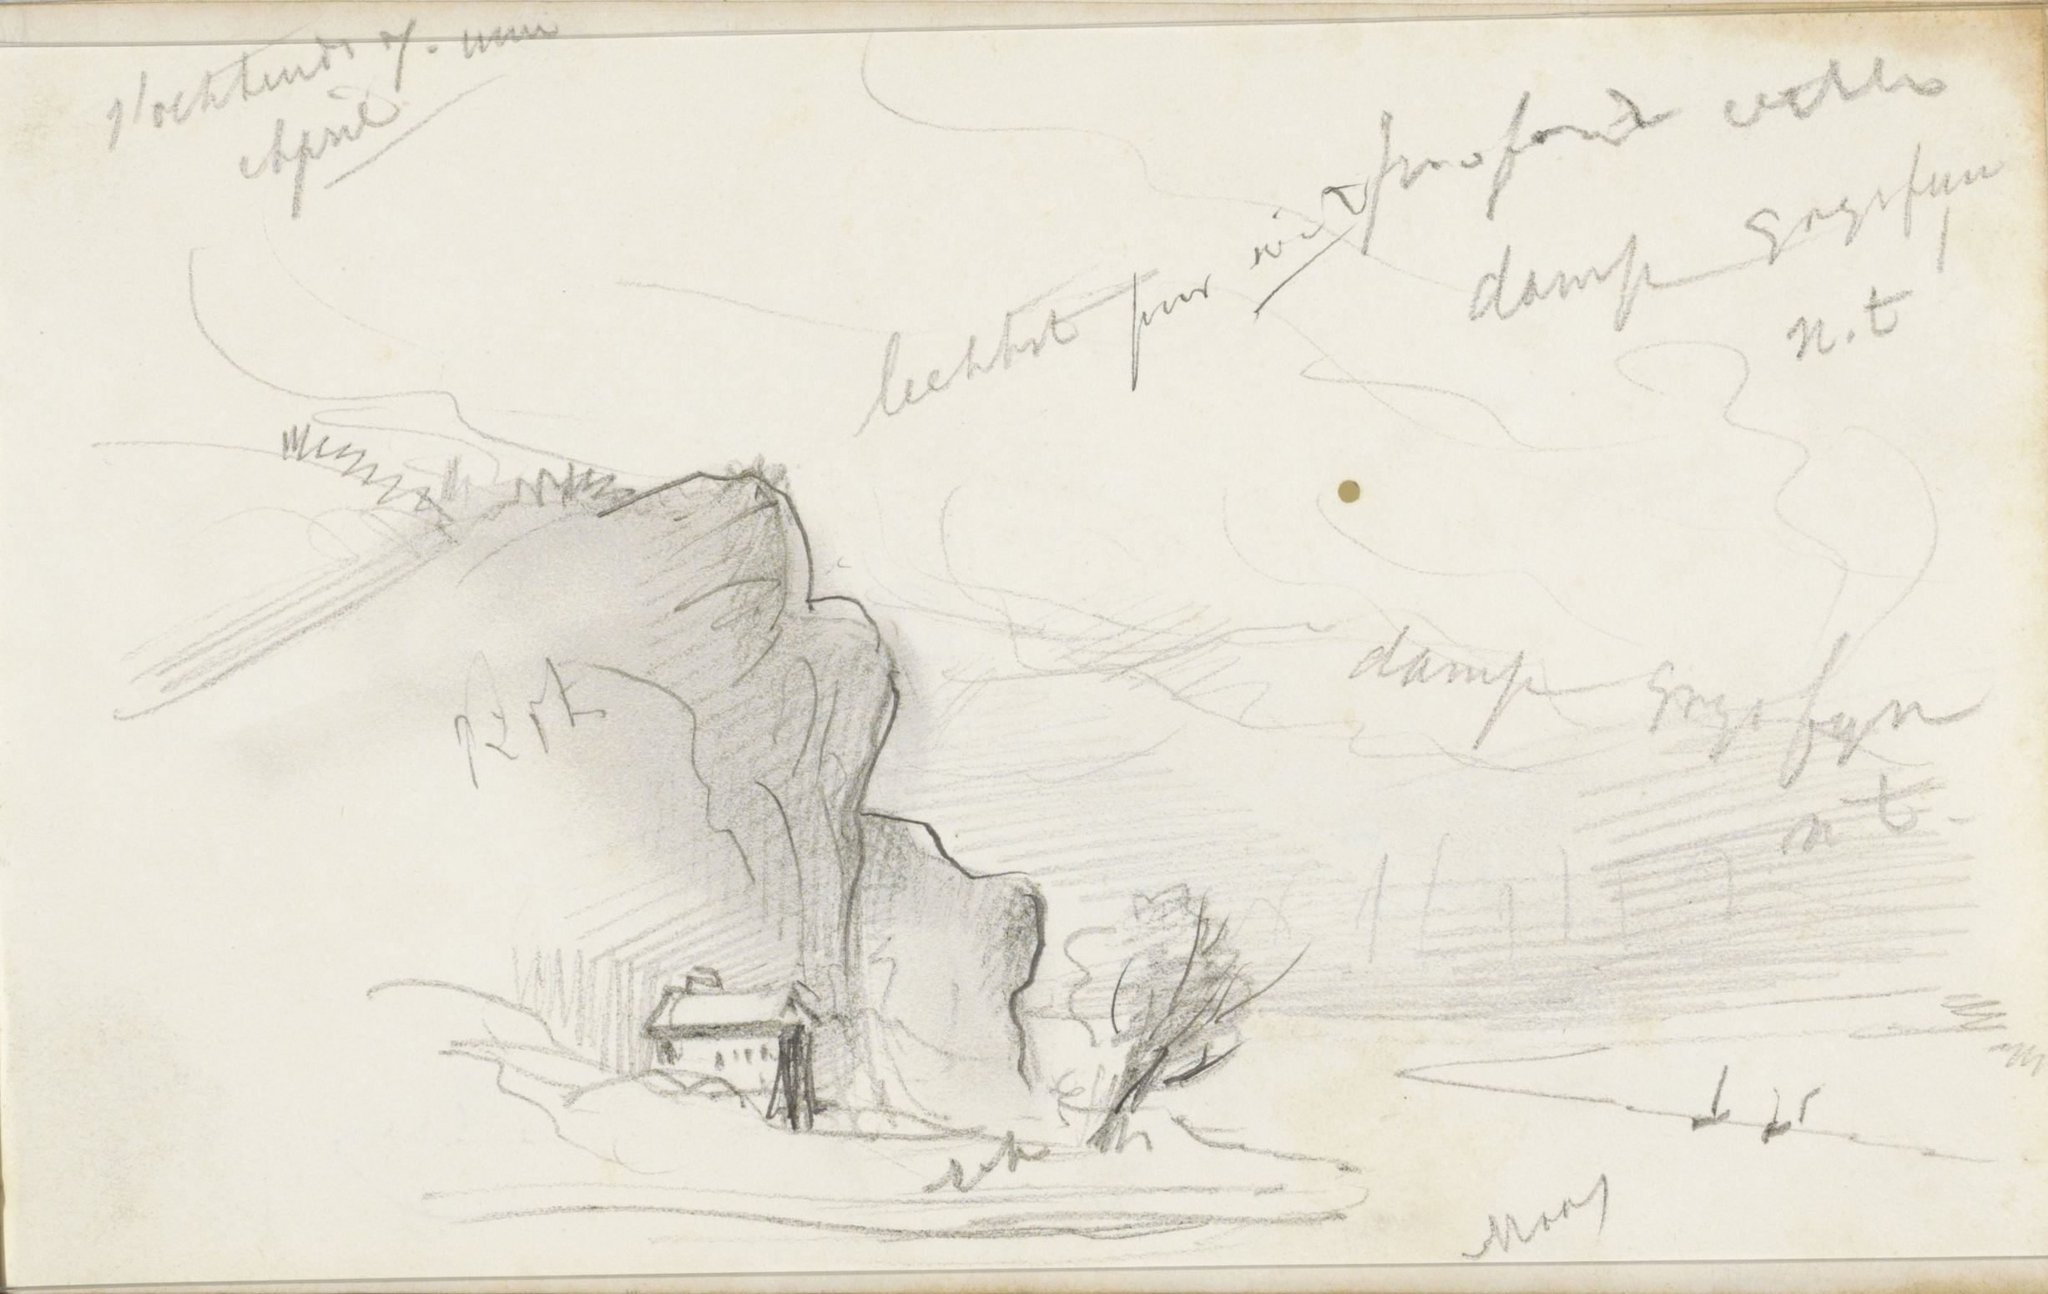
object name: sketchbook leaf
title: Huis bij een rots aan de oever van de Maas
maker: johannes tavenraat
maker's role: draughtsman, painter, print maker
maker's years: 1809-1881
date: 1840-1841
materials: paper, pencil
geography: meuse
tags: river bank, landscapes with waters, waterscapes, seascapes (in the temperate zone), rural housing, e.g. country-house, villa, cottage, rocks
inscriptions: annotation: ‘s'ochtends 7 uur/ April/ Rots/ Maas’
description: Blad 15 recto uit een schetsboek met 41 bladen.